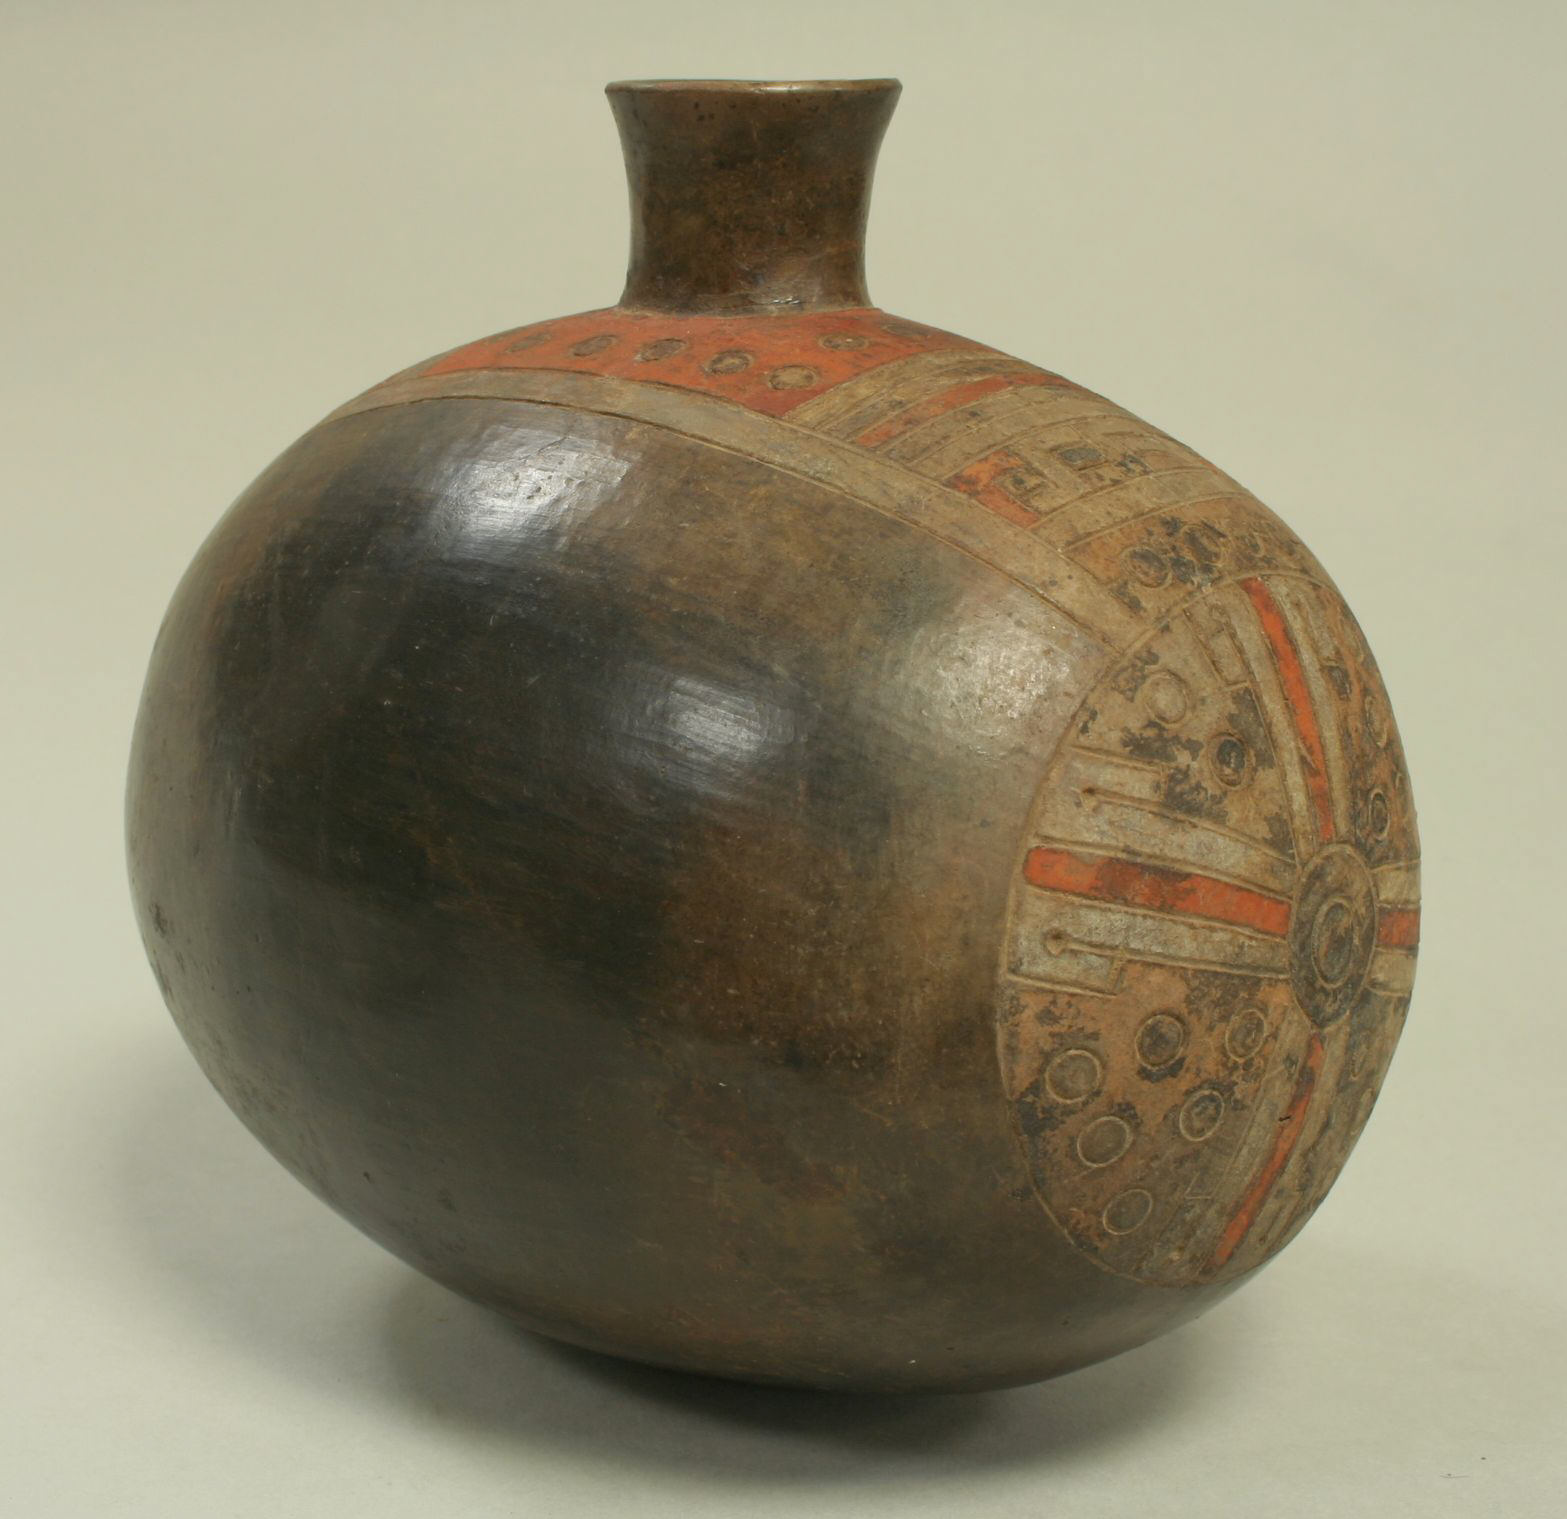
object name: bottle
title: Single Spout Bottle in Melon Form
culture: paracas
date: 500-201 BCE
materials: ceramic, pigment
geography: peru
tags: fruit